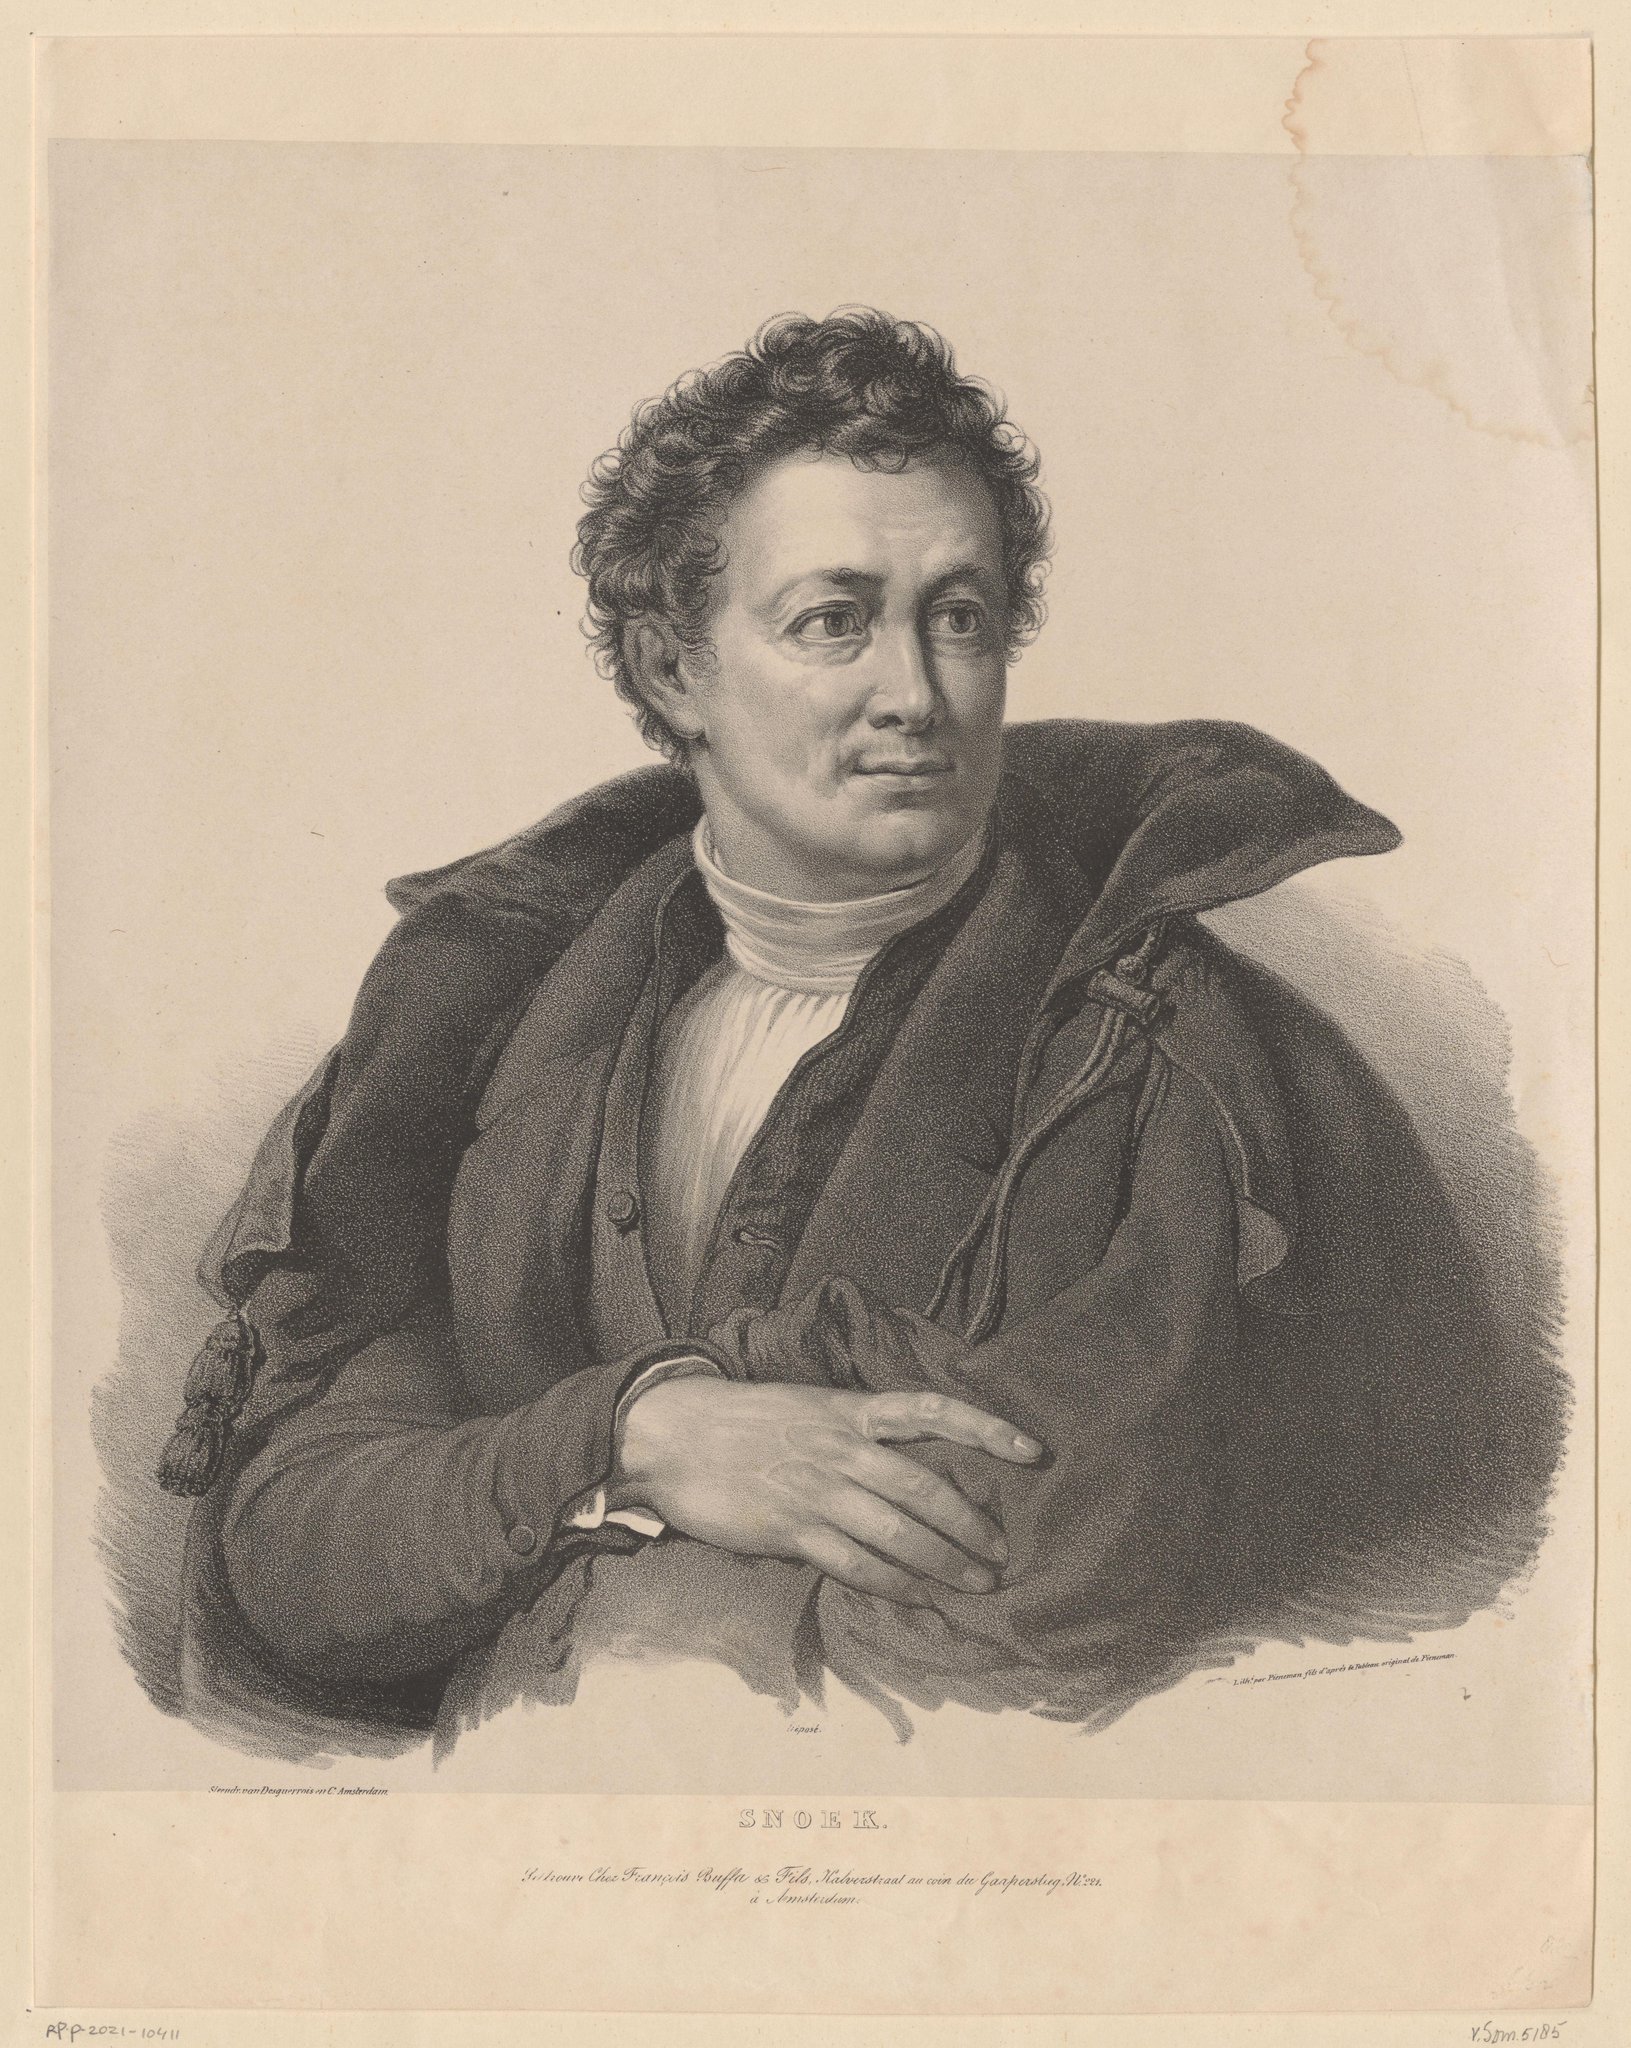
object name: print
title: Portret van Andreas Snoek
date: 1829-1860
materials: paper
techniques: lithograph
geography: amsterdam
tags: amsterdam, adult man, historical persons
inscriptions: : ‘Déposé’